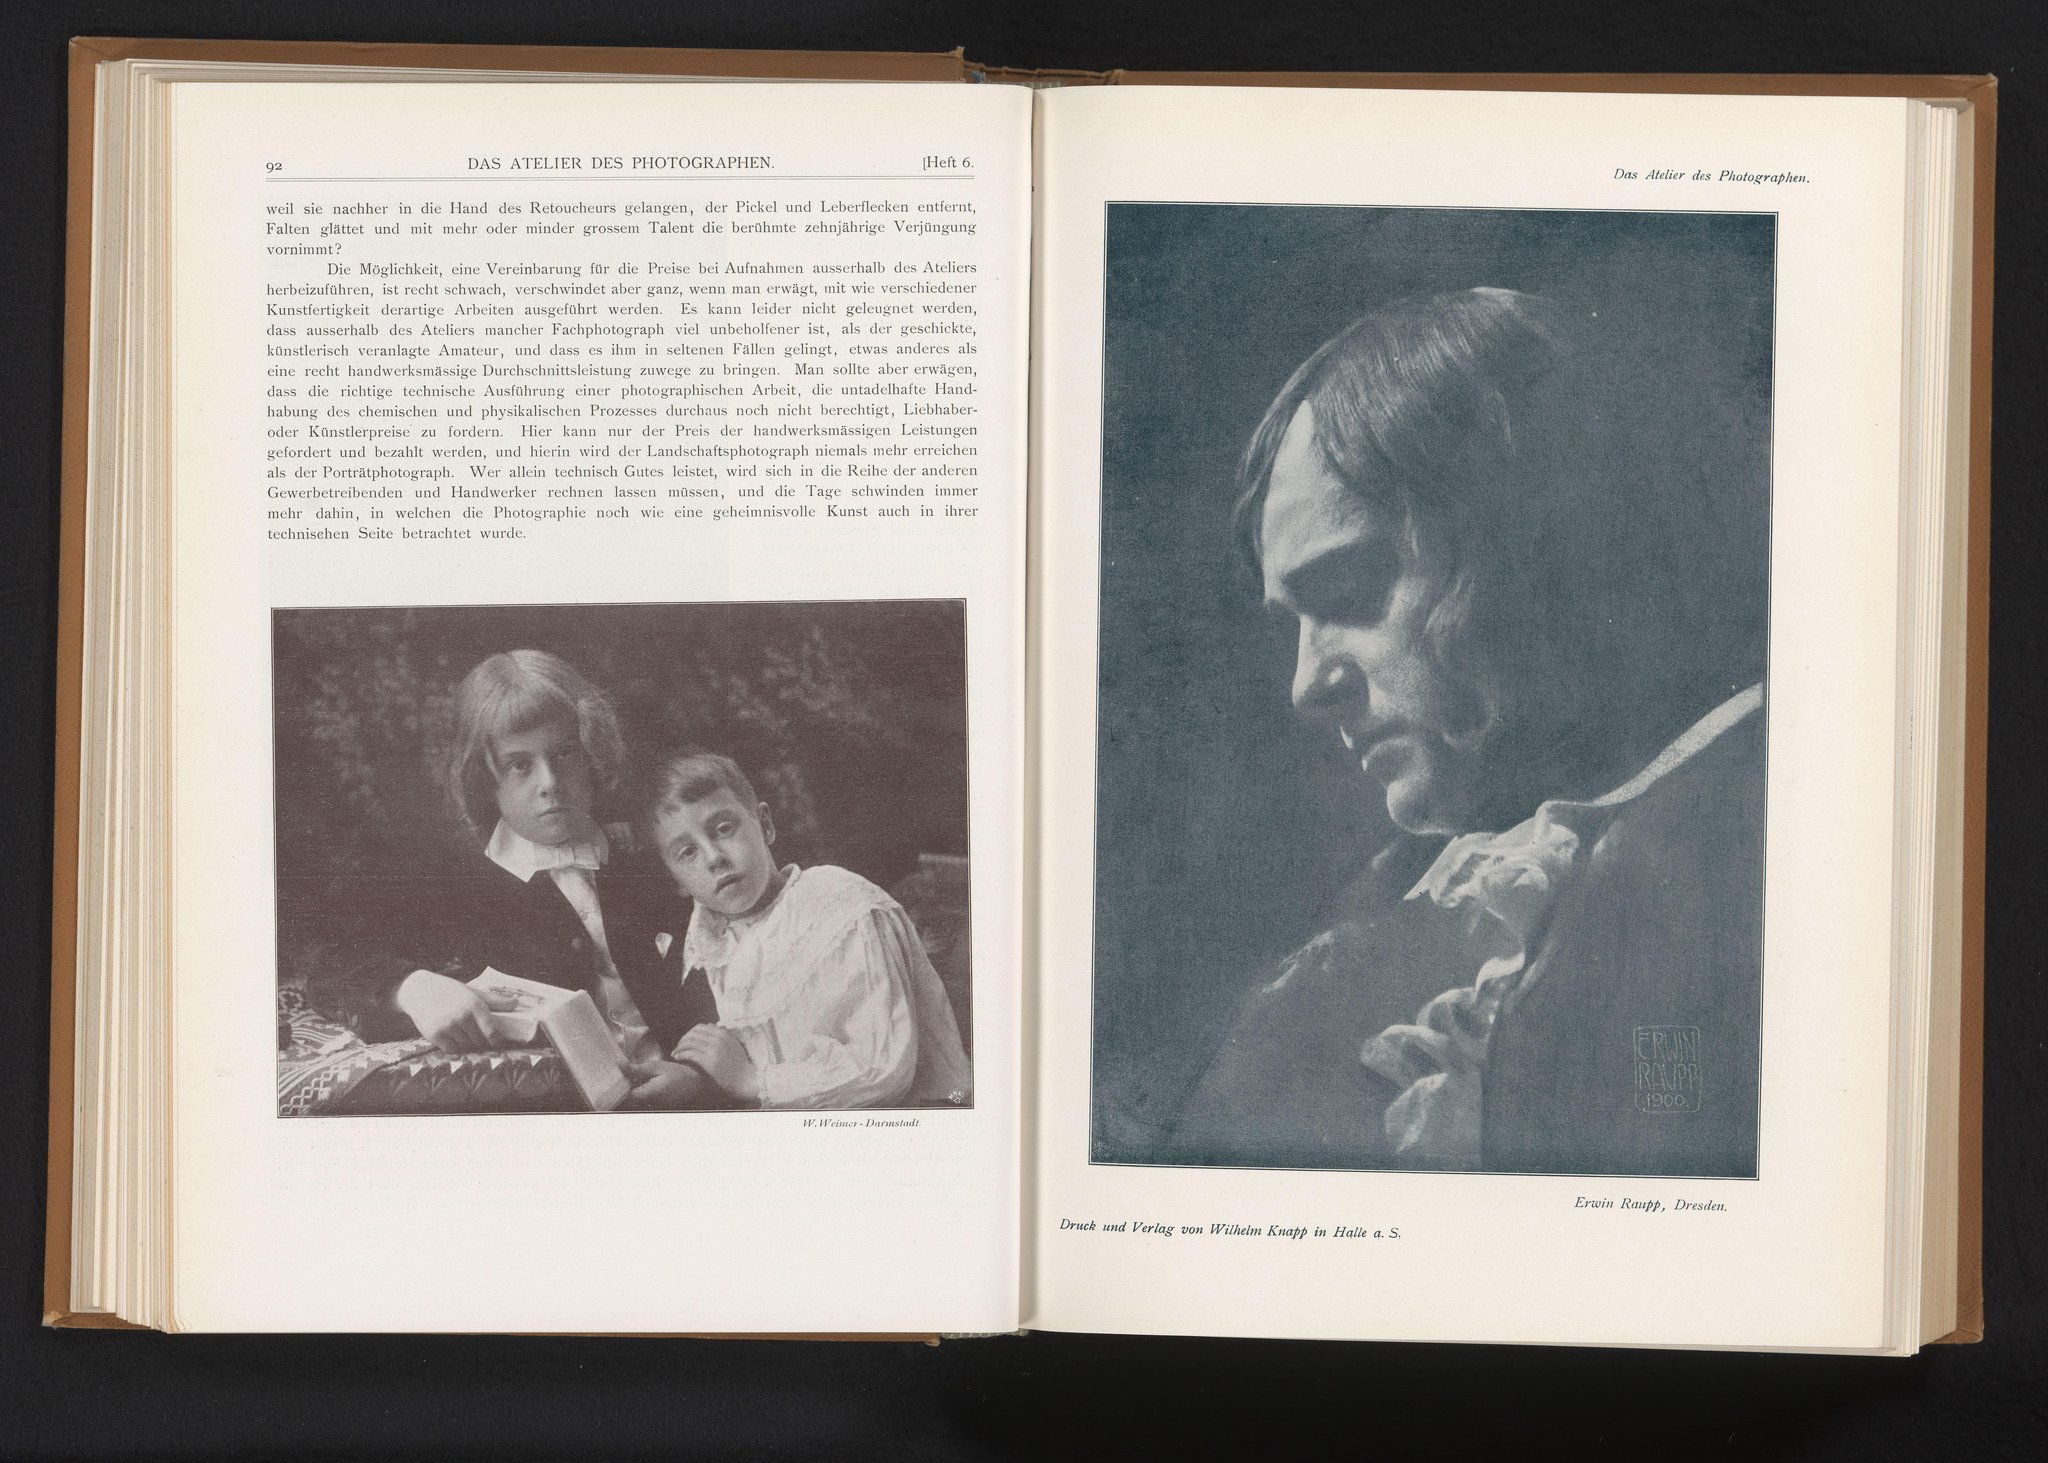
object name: photomechanical print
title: Portret van een onbekende man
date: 1895-1900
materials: paper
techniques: autotype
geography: halle an der saale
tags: historical persons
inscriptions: monogram: ‘LEIPZIG/ S G’, inscription: ‘Das Atelier des Photographen.’